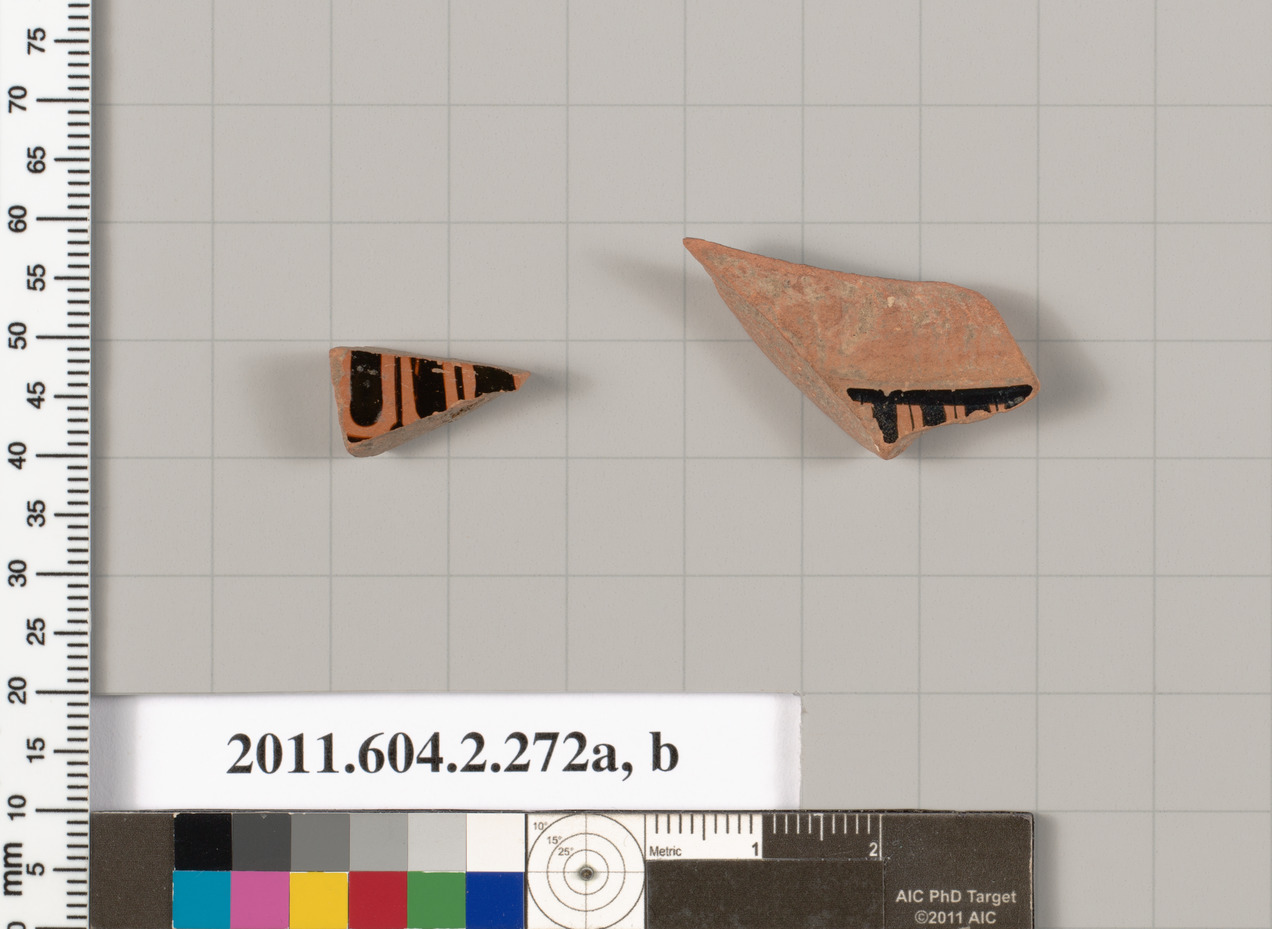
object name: stamnoi fragment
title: Terracotta fragments of stamnoi (jars)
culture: greek, attic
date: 500-451 BCE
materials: terracotta